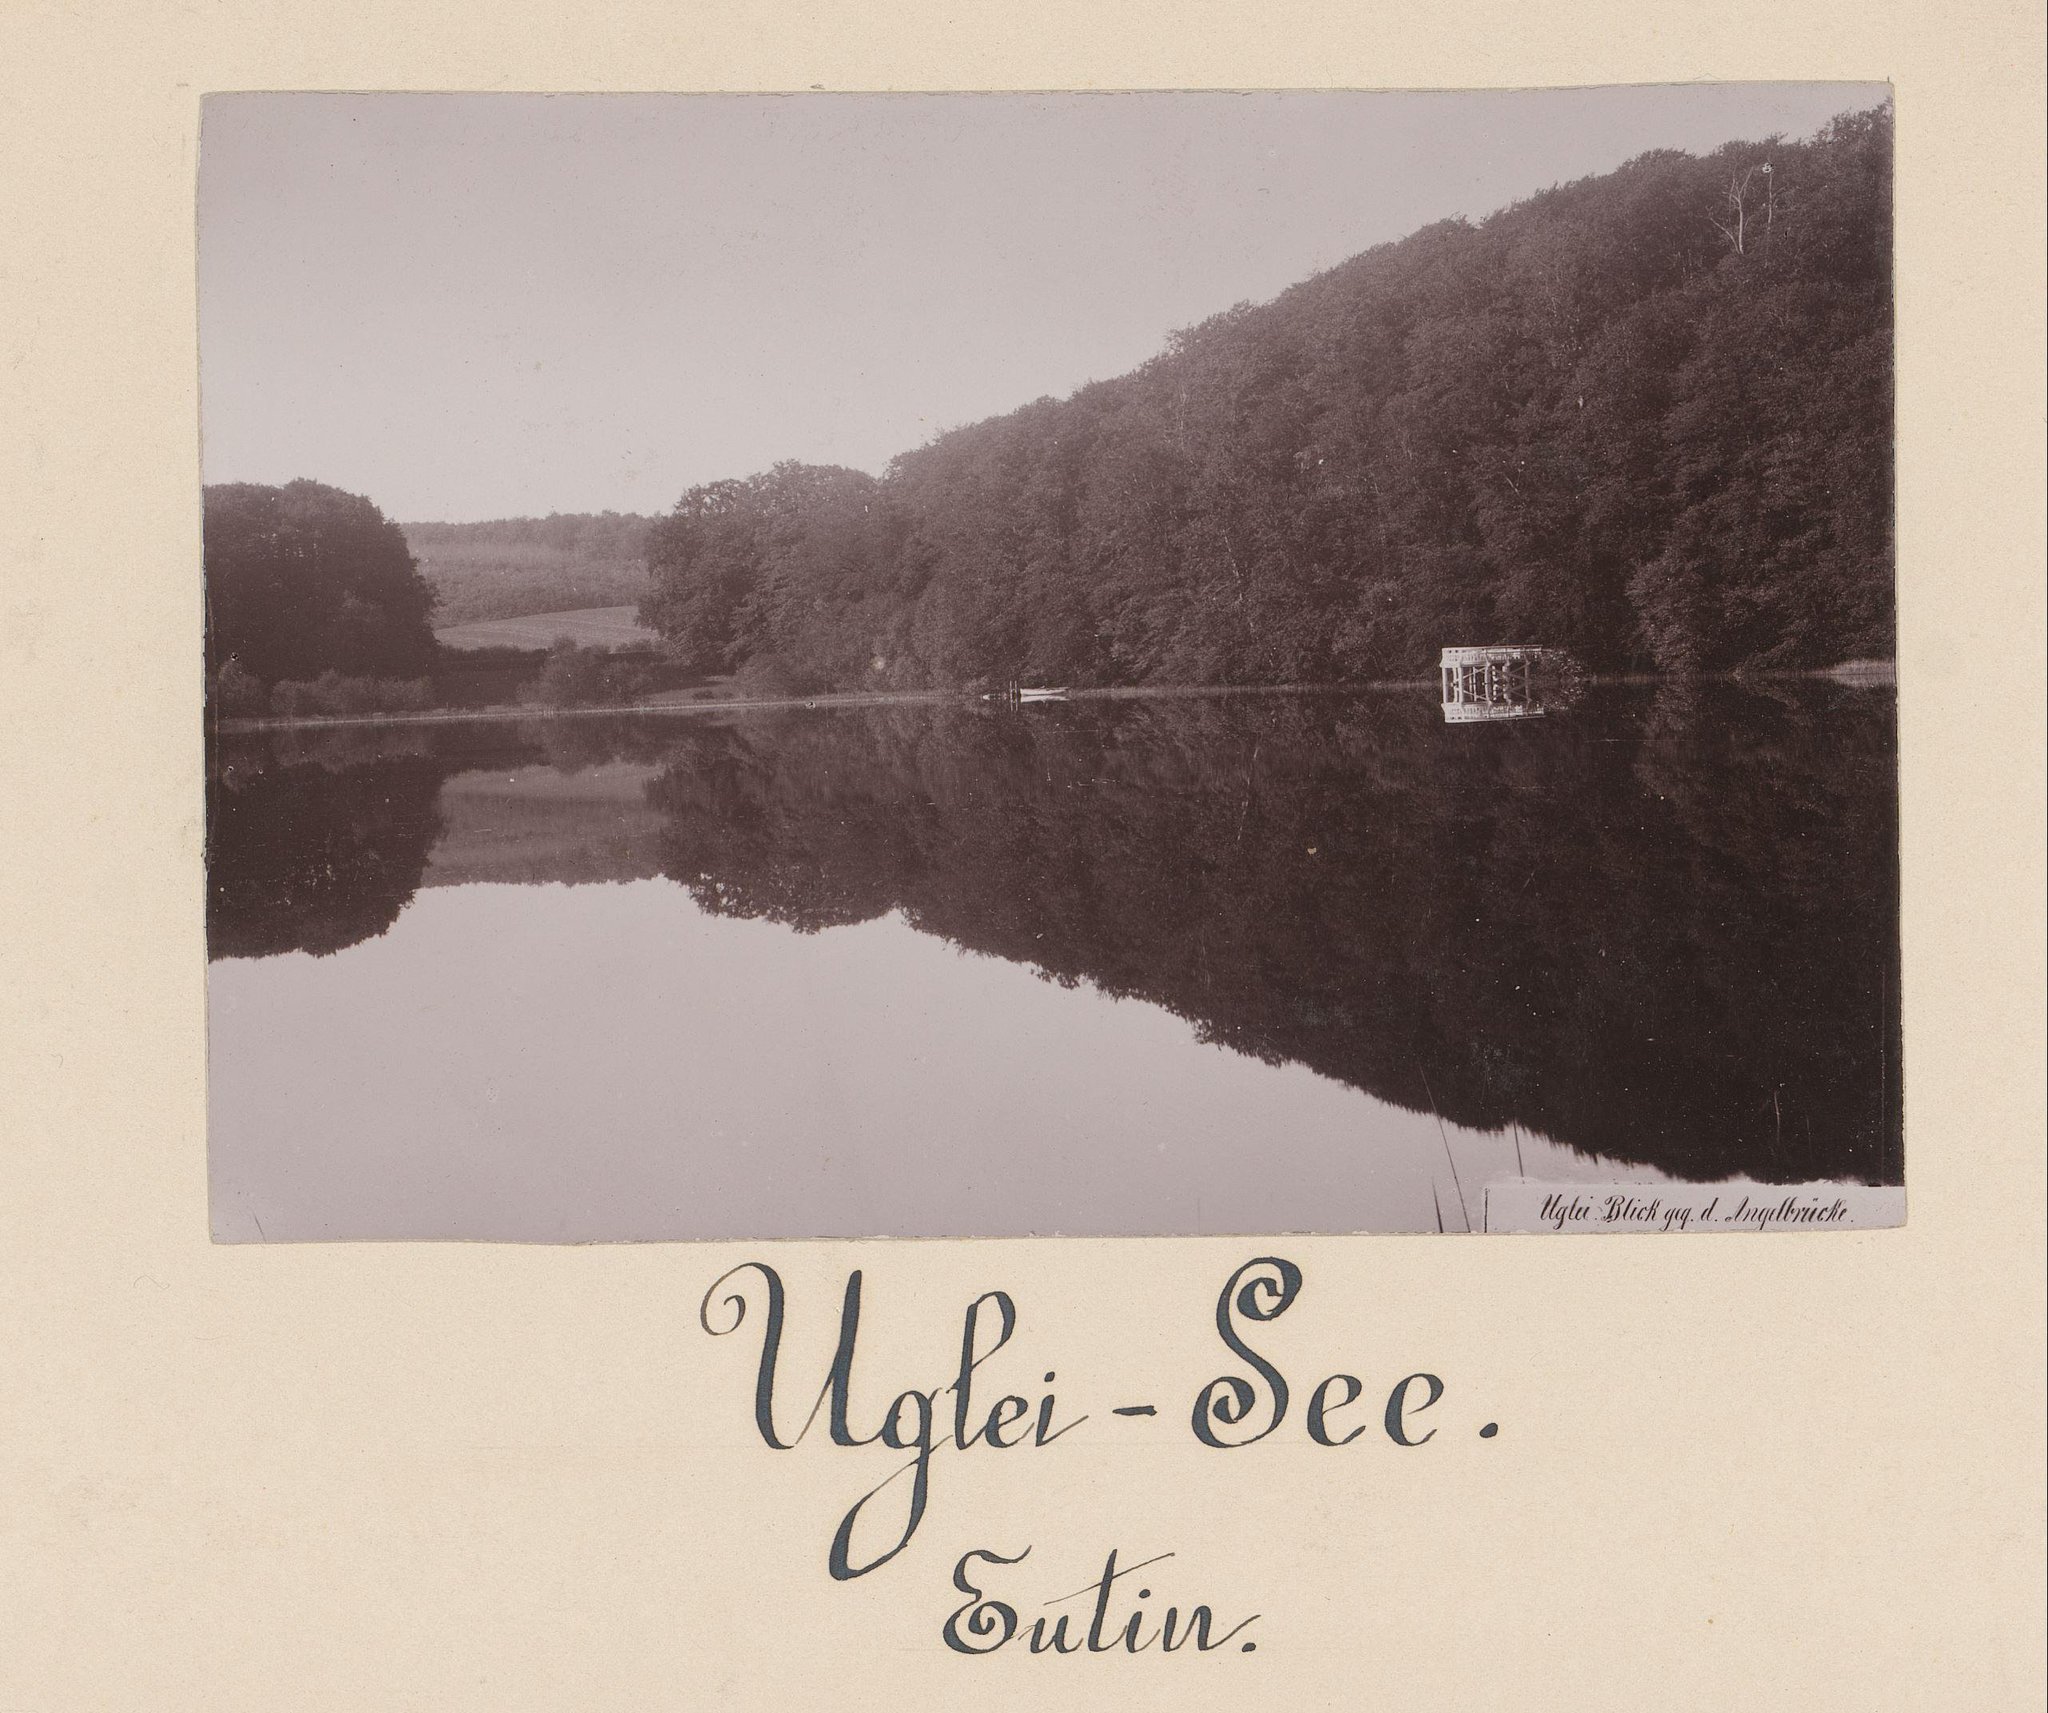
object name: photograph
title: Holstein. Uglei-See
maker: Anonymous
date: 1890-1910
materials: paper, cardboard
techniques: gelatin silver print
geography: ukleisee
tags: lake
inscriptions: inscription: ‘Uglei. Blick geg. d. Angelbrücke’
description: Deze foto maakt deel uit van een omslag.